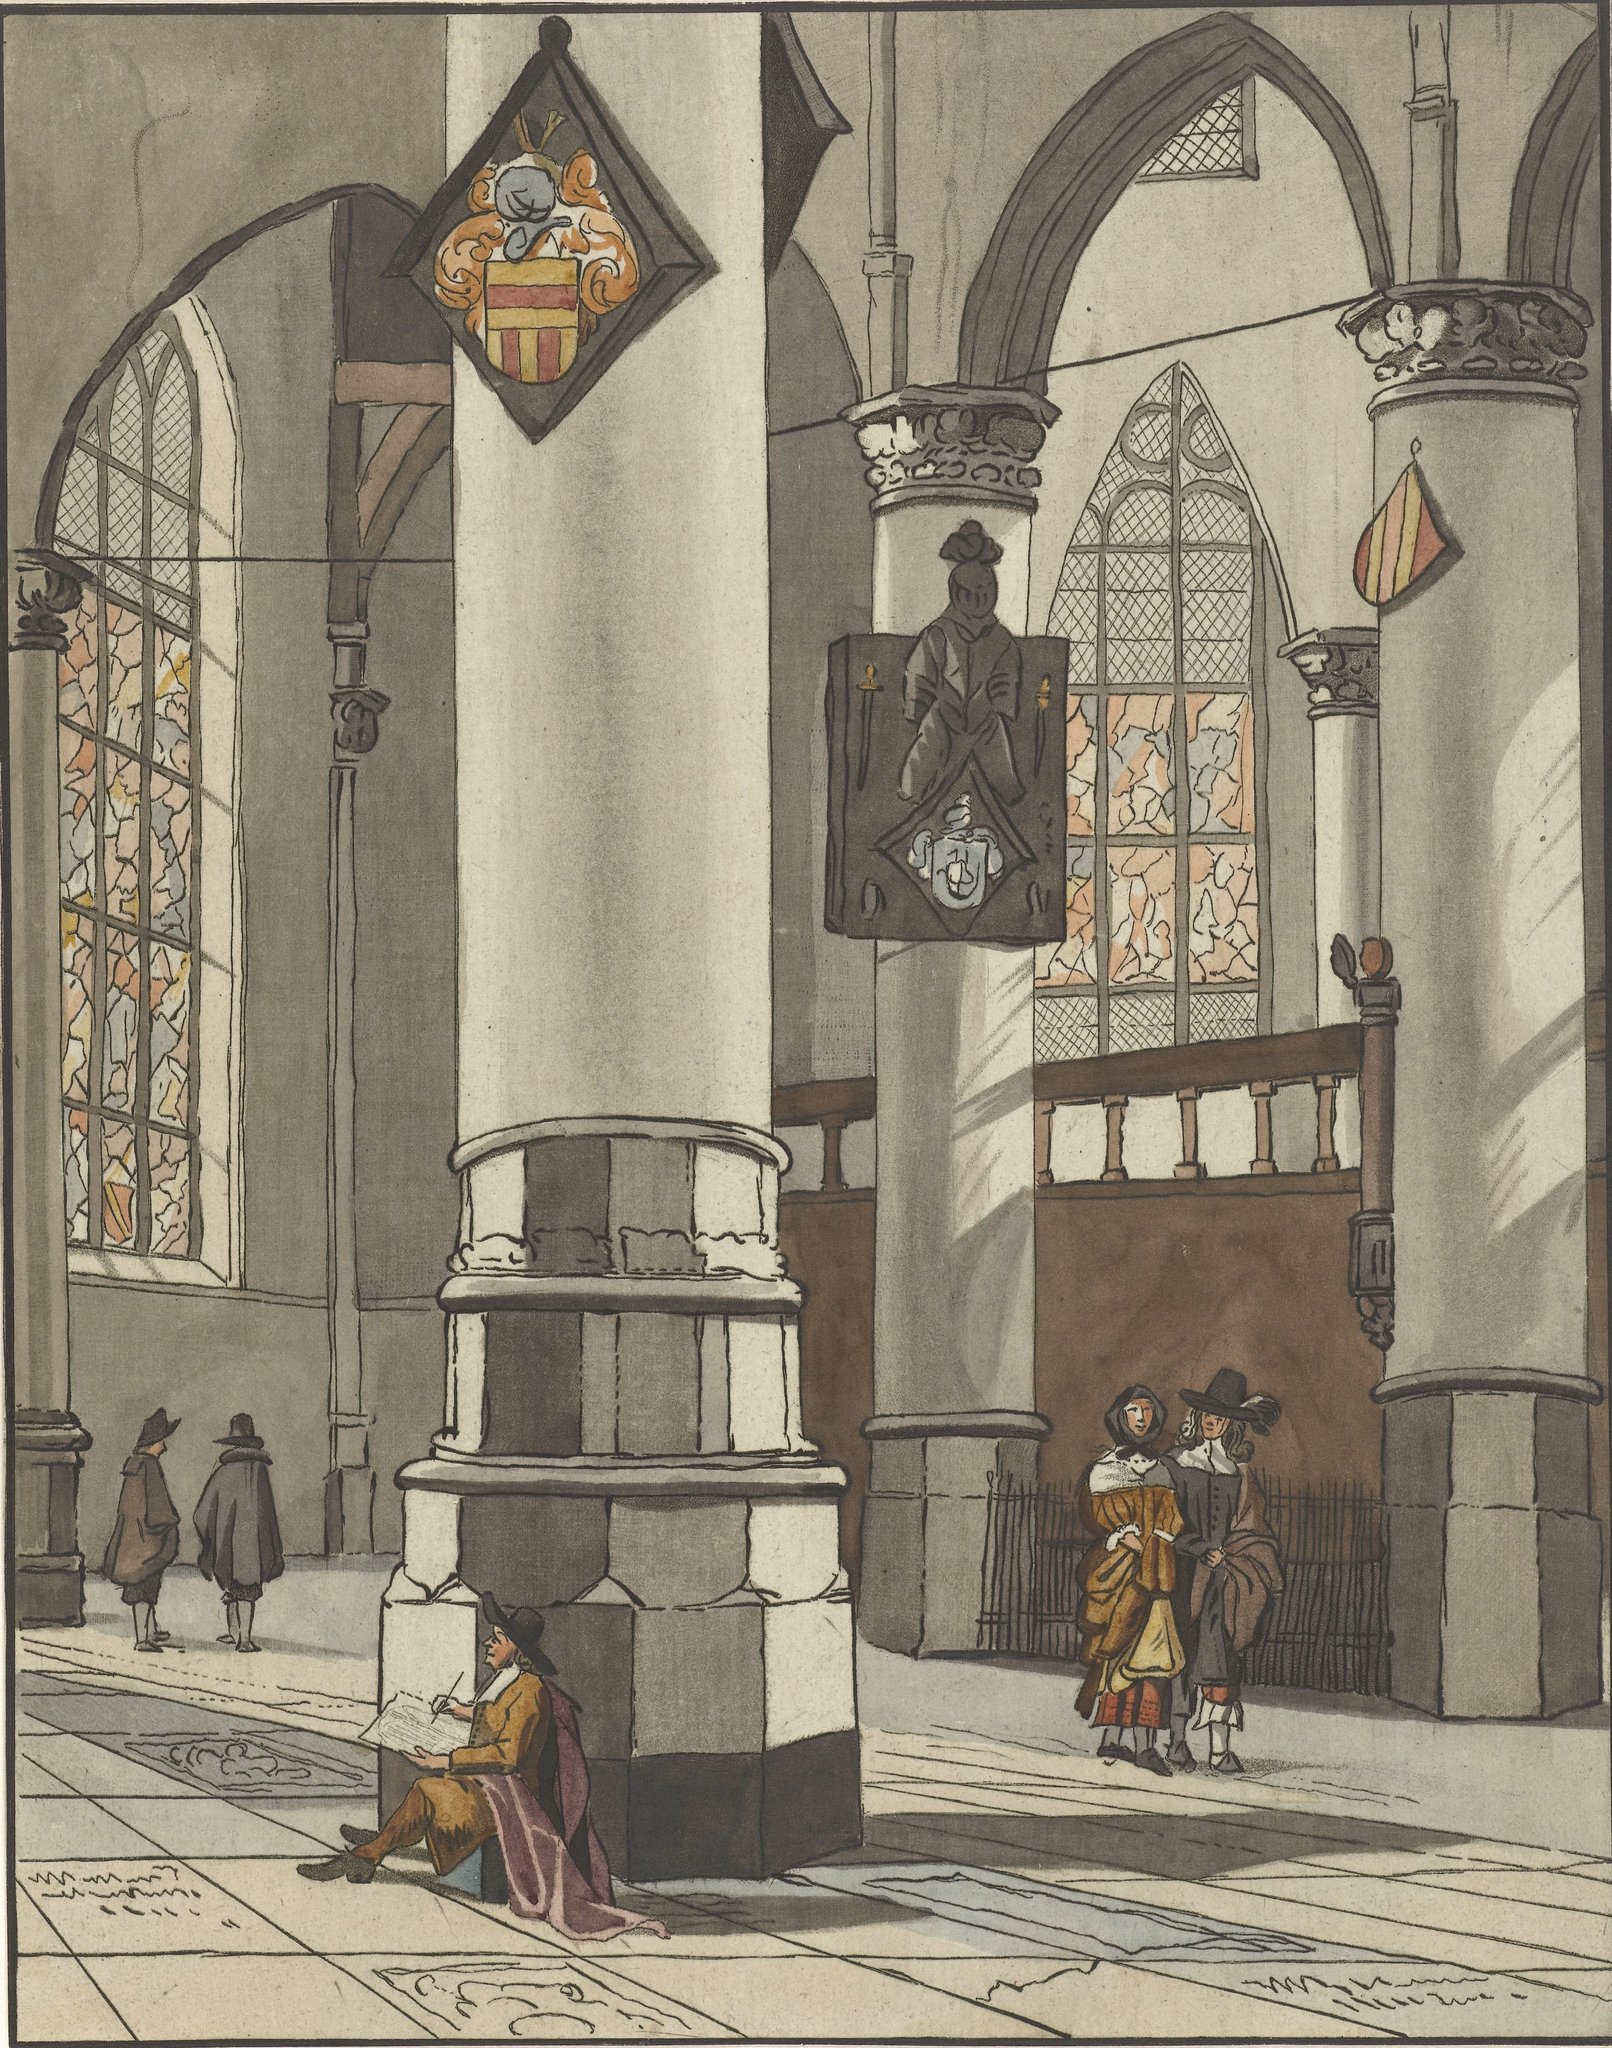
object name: print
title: Kerkinterieur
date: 1774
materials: paper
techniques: etching, hand coloring, roulette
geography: amsterdam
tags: interior of church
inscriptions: collector's mark: Lugt 12, collector's mark: Lugt 2725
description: Interieur van een kerk. Aan de voet van een pilaar zit een kunstenaar te tekenen. Rechts lopen een gearmde man en een vrouw.